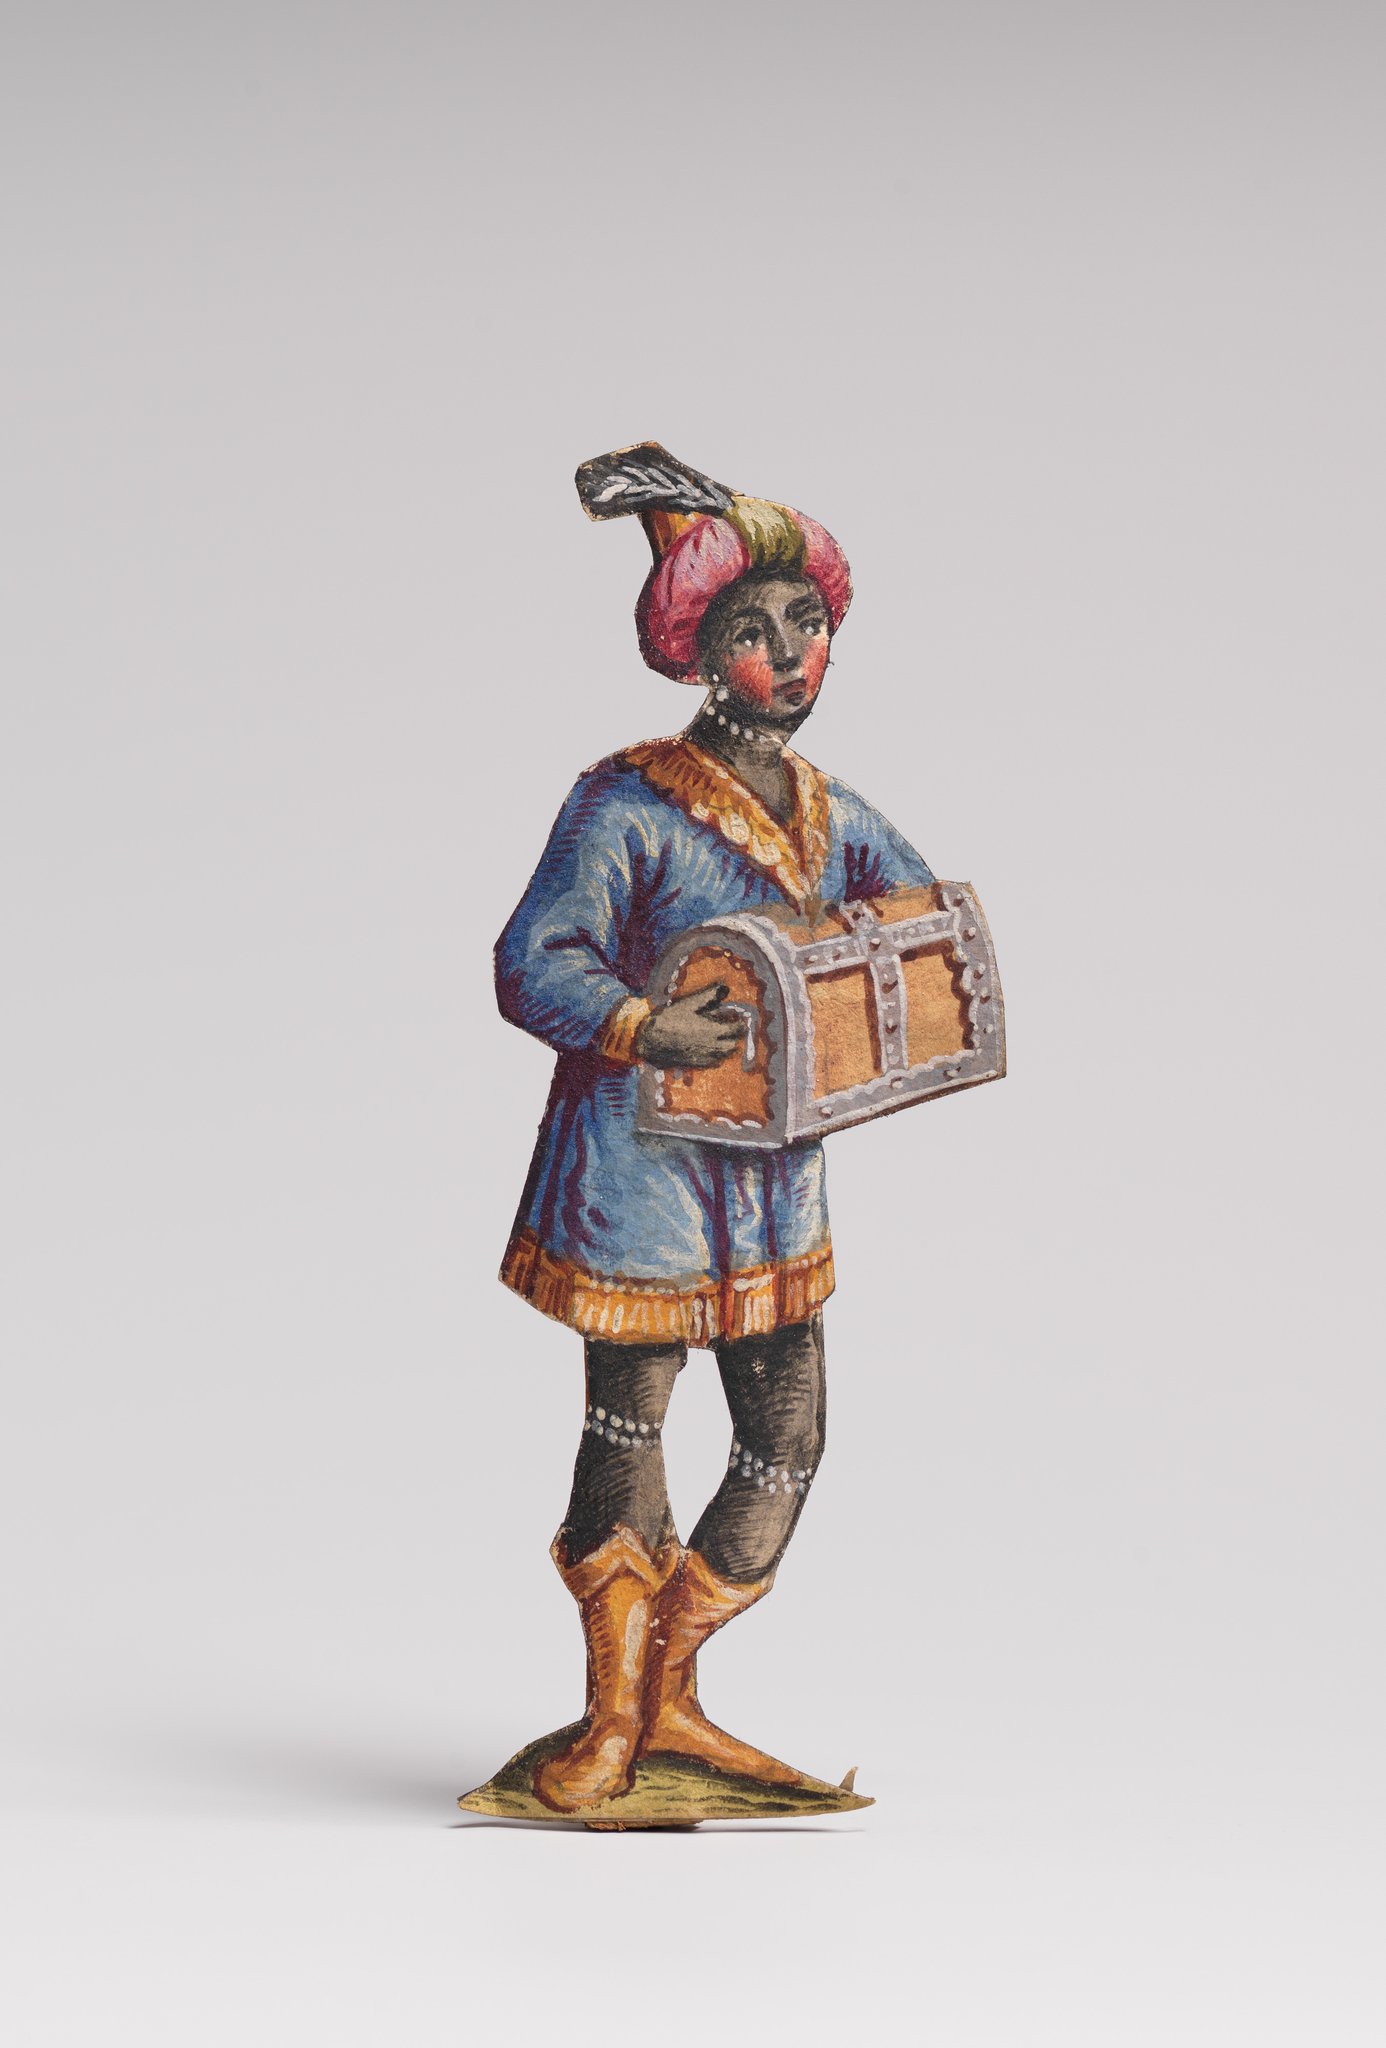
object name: figure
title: Attendant with coffer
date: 1701-1800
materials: gouache, paper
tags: men